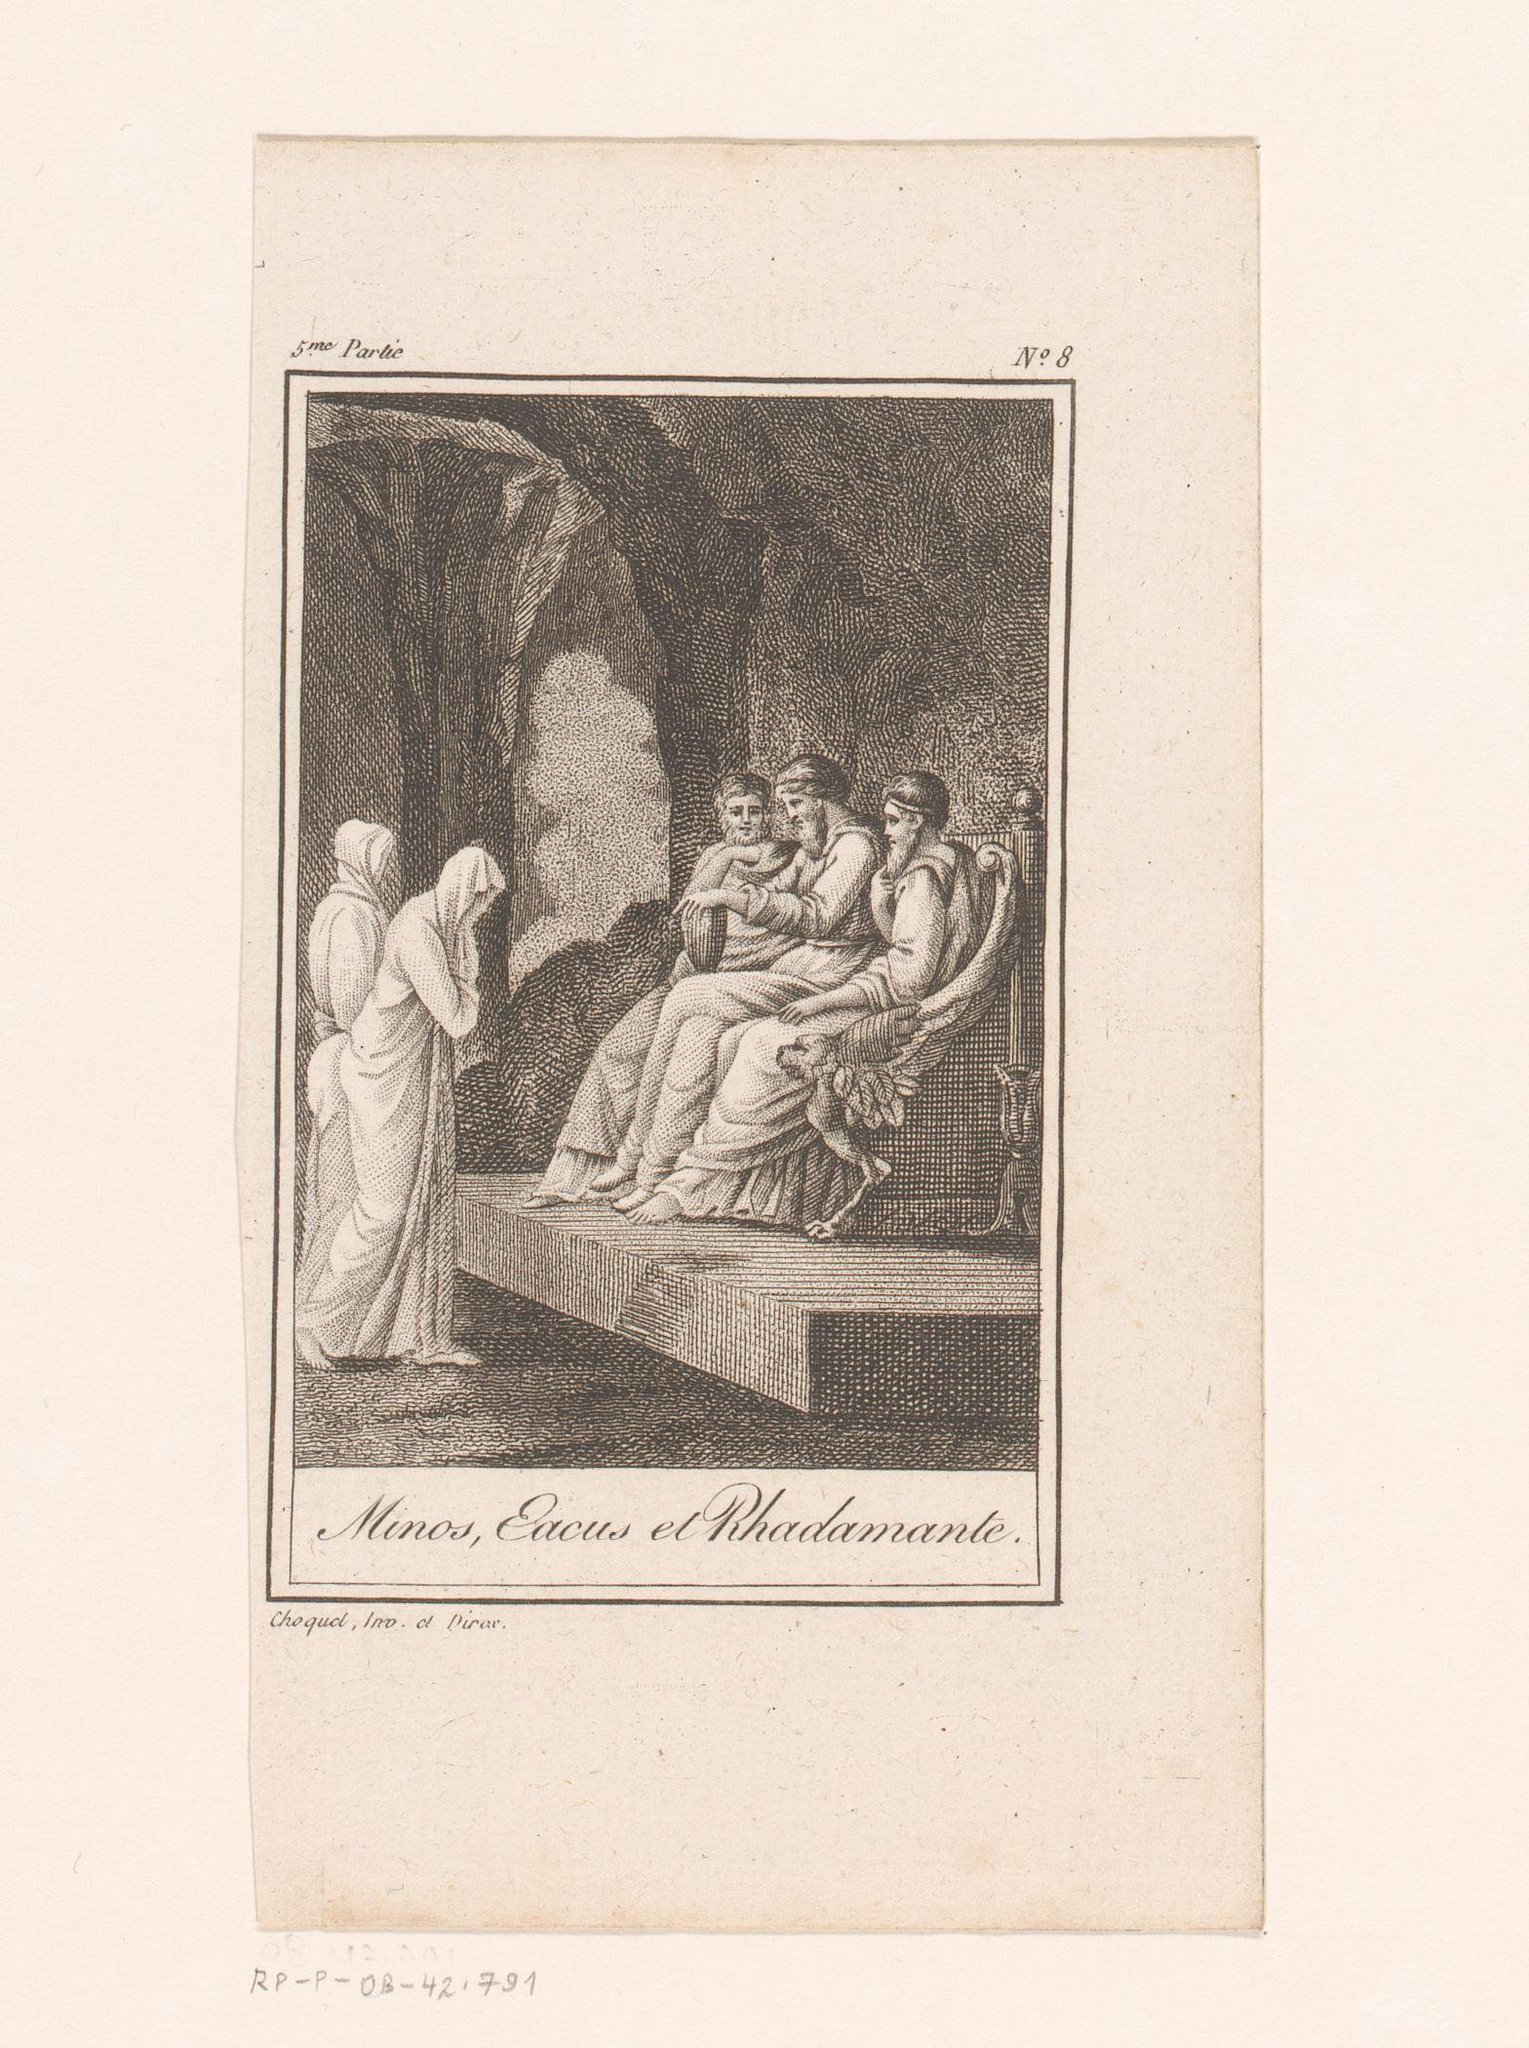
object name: print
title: Minos, Eacus et Rhadamante.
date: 1784-1824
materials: paper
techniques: engraving, etching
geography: france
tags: aecus (as judge of hades), rhadamanthus (as judge of hades), minos (as judge of hades)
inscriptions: collector's mark: Lugt 2228